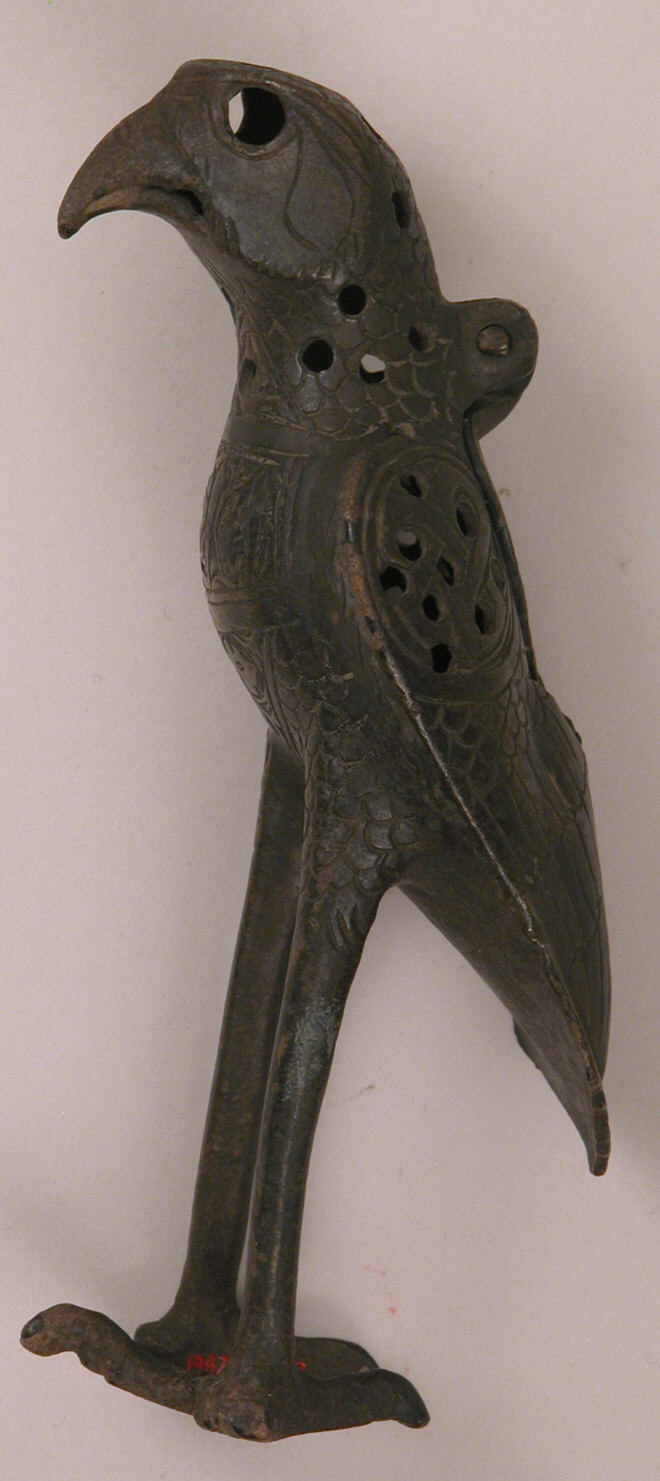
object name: incense burner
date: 1201-1300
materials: brass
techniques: casting, incising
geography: iran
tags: birds